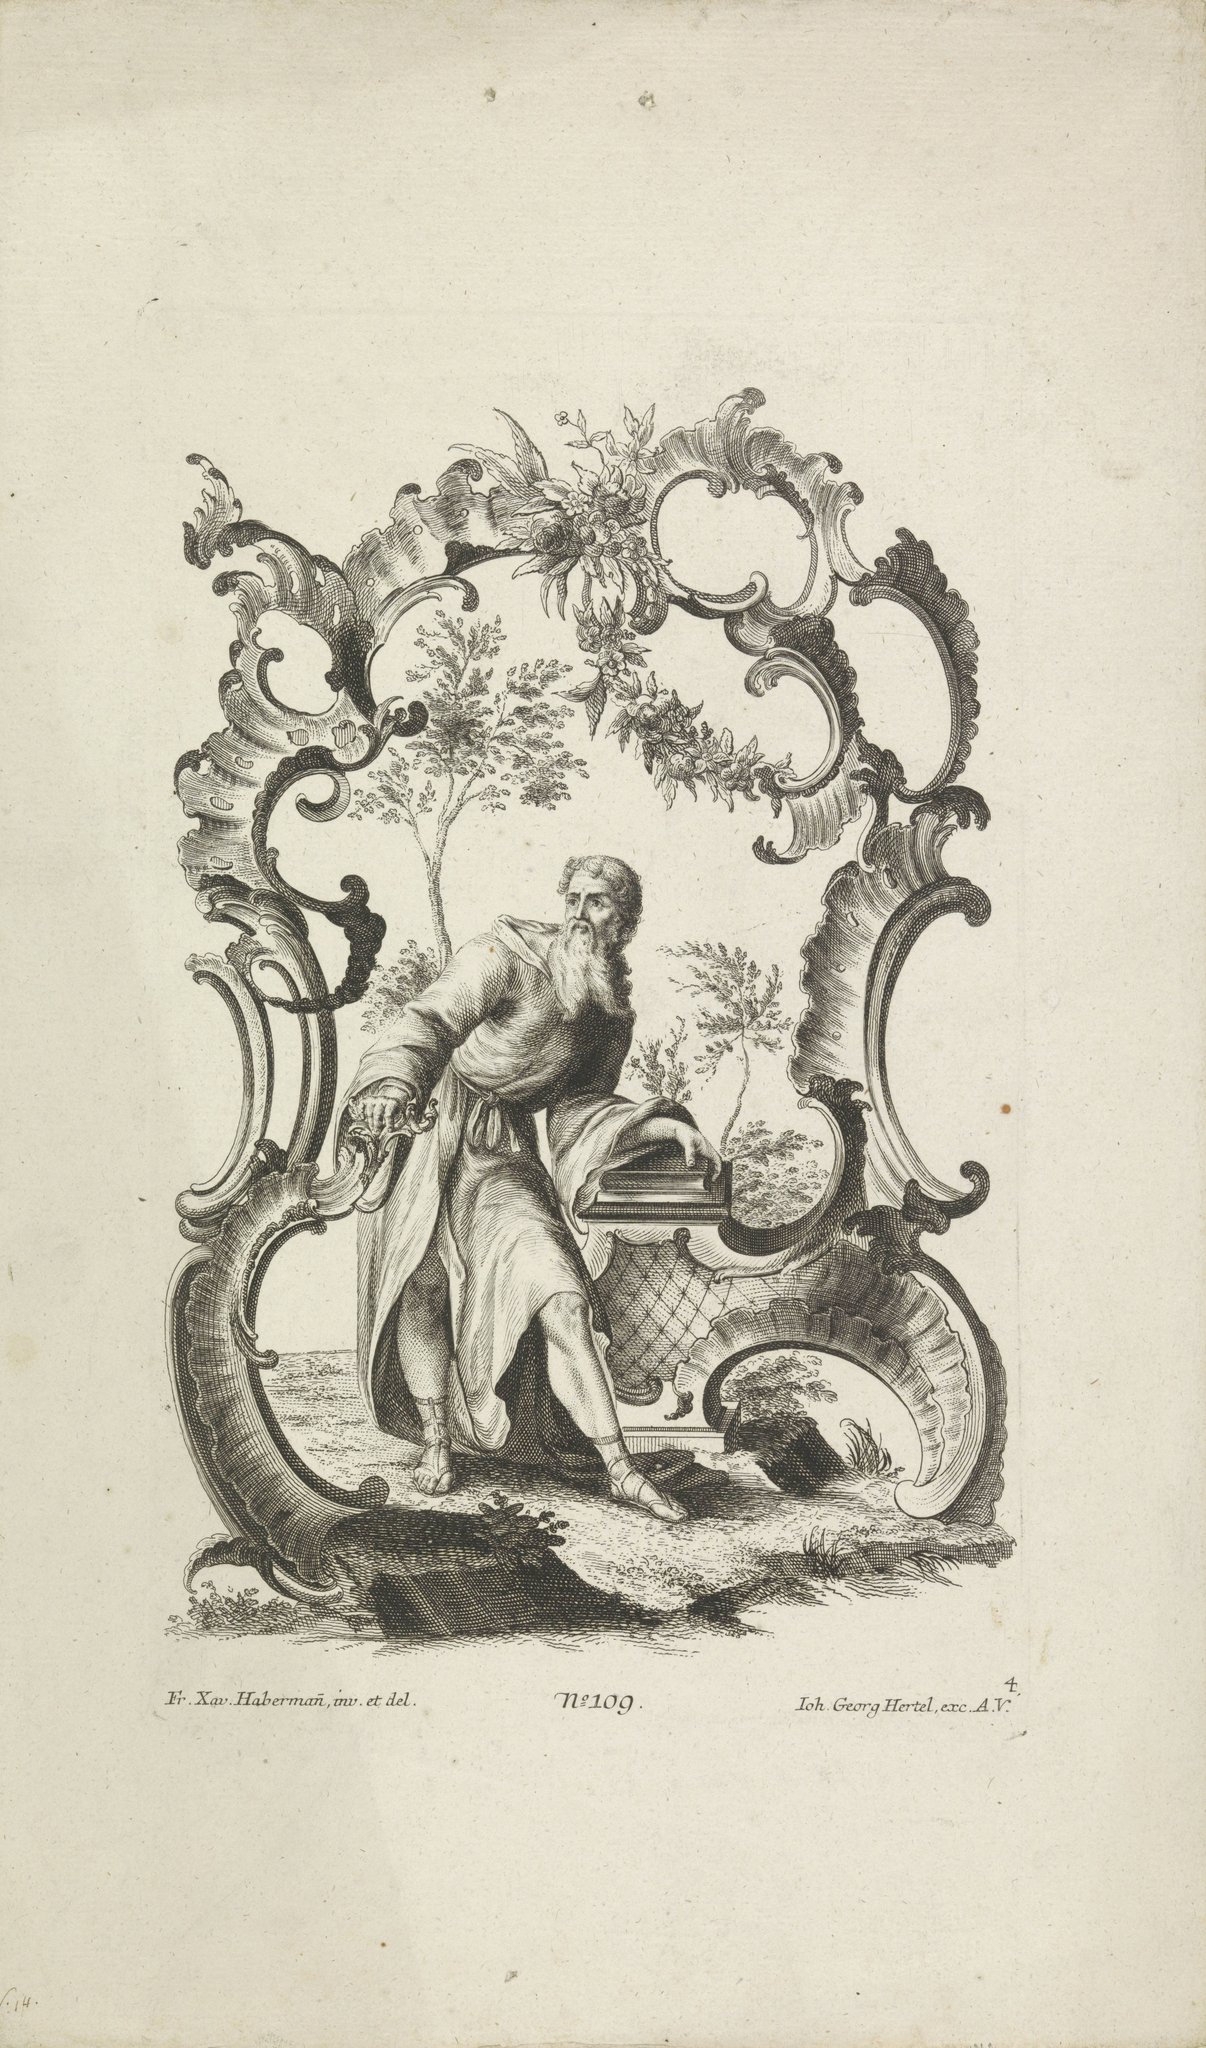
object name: ornament print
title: Rocaille omraming met oude man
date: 1731-1775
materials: paper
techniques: etching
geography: augsburg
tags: rocaille ornament, old man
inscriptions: collector's mark: Lugt 2760, collector's mark: Lugt 2228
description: Rocaille omraming met guirlande, met oude man met boek in landschap. Uitgeversnummer 109.